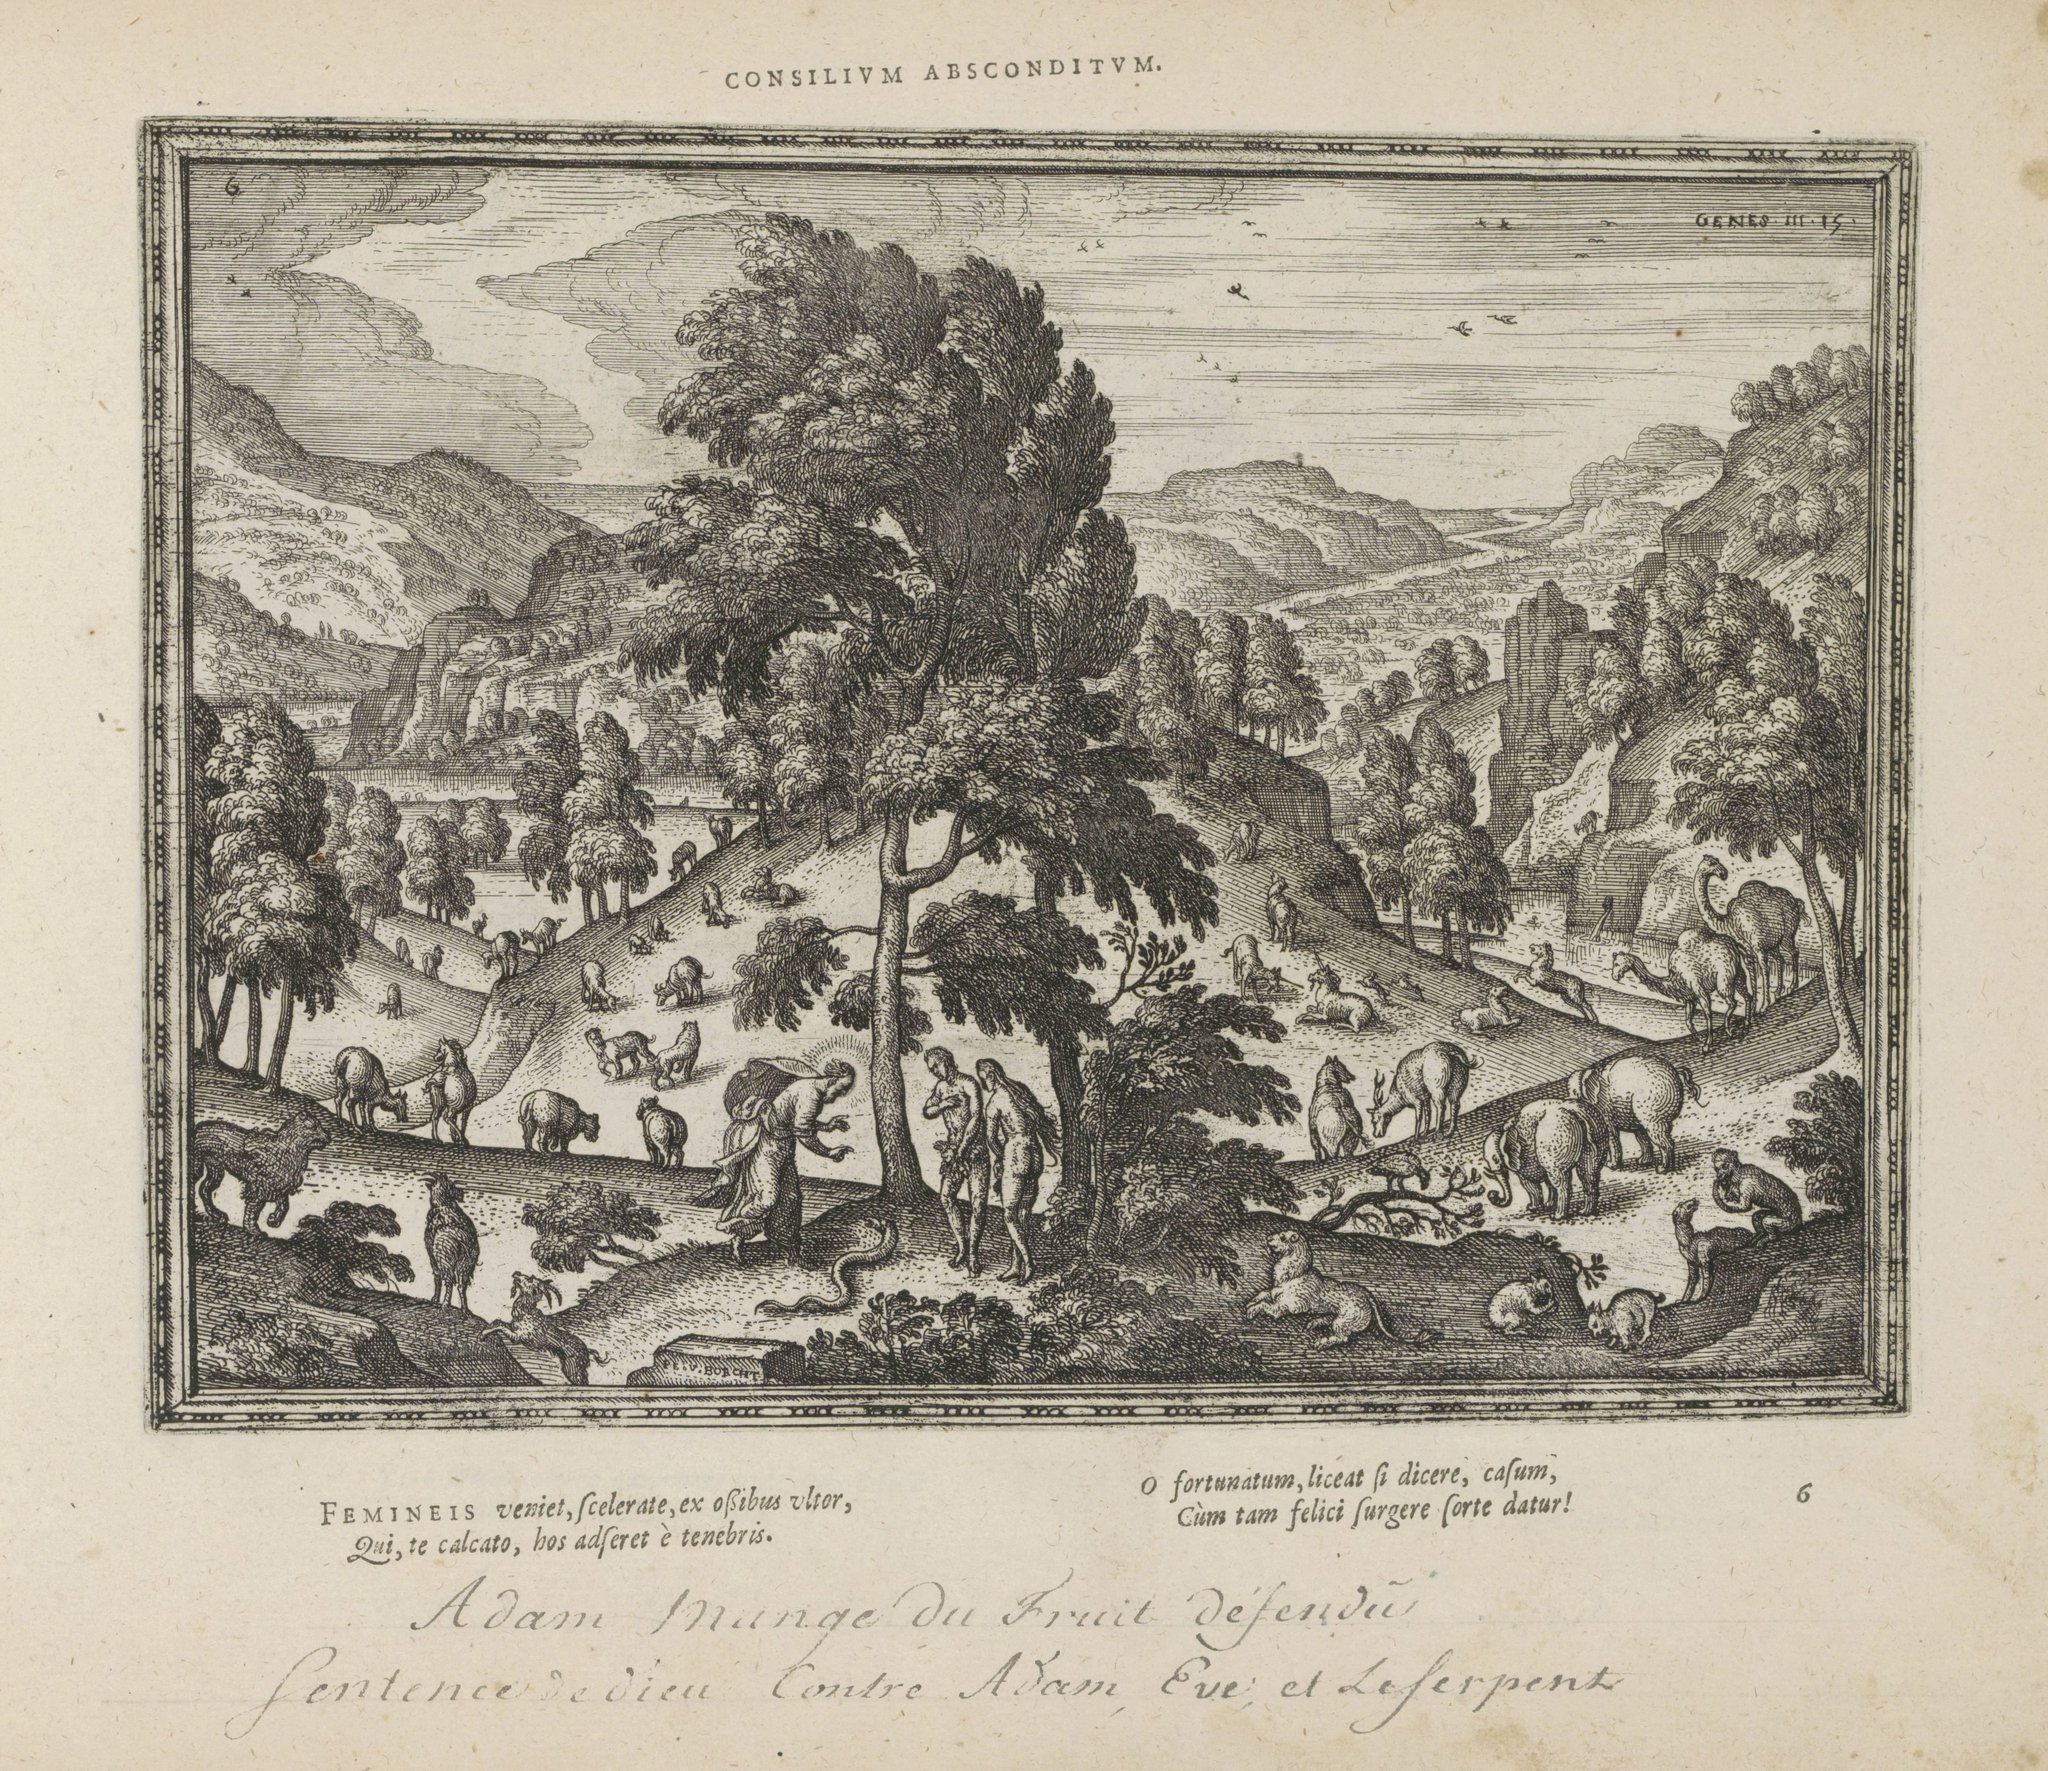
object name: album leaf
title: Consilium absconditum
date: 1582-1593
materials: paper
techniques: etching, letterpress printing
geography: antwerp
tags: the snake is cursed by god, and condemned to eat dust and to crawl on its belly, animals, the tree of knowledge of good and evil (whose fruit, usually apples or figs, brings death); the tree may be guarded by the serpent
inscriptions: inscription: ‘Adam Mange du Fruit défendu sentence de Dieu Contre Adam, Eve, et Le serpent’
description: Te midden van de dieren en bij de boom der kennis van goed en kwaad vervloekt God de slang. Adam en Eva staan ernaast (Gen. 2:14). Met een motto in het Latijn boven de voorstelling en een vierregelig onderschrift in het Latijn onder de prent. De prent maakt deel uit van een album.